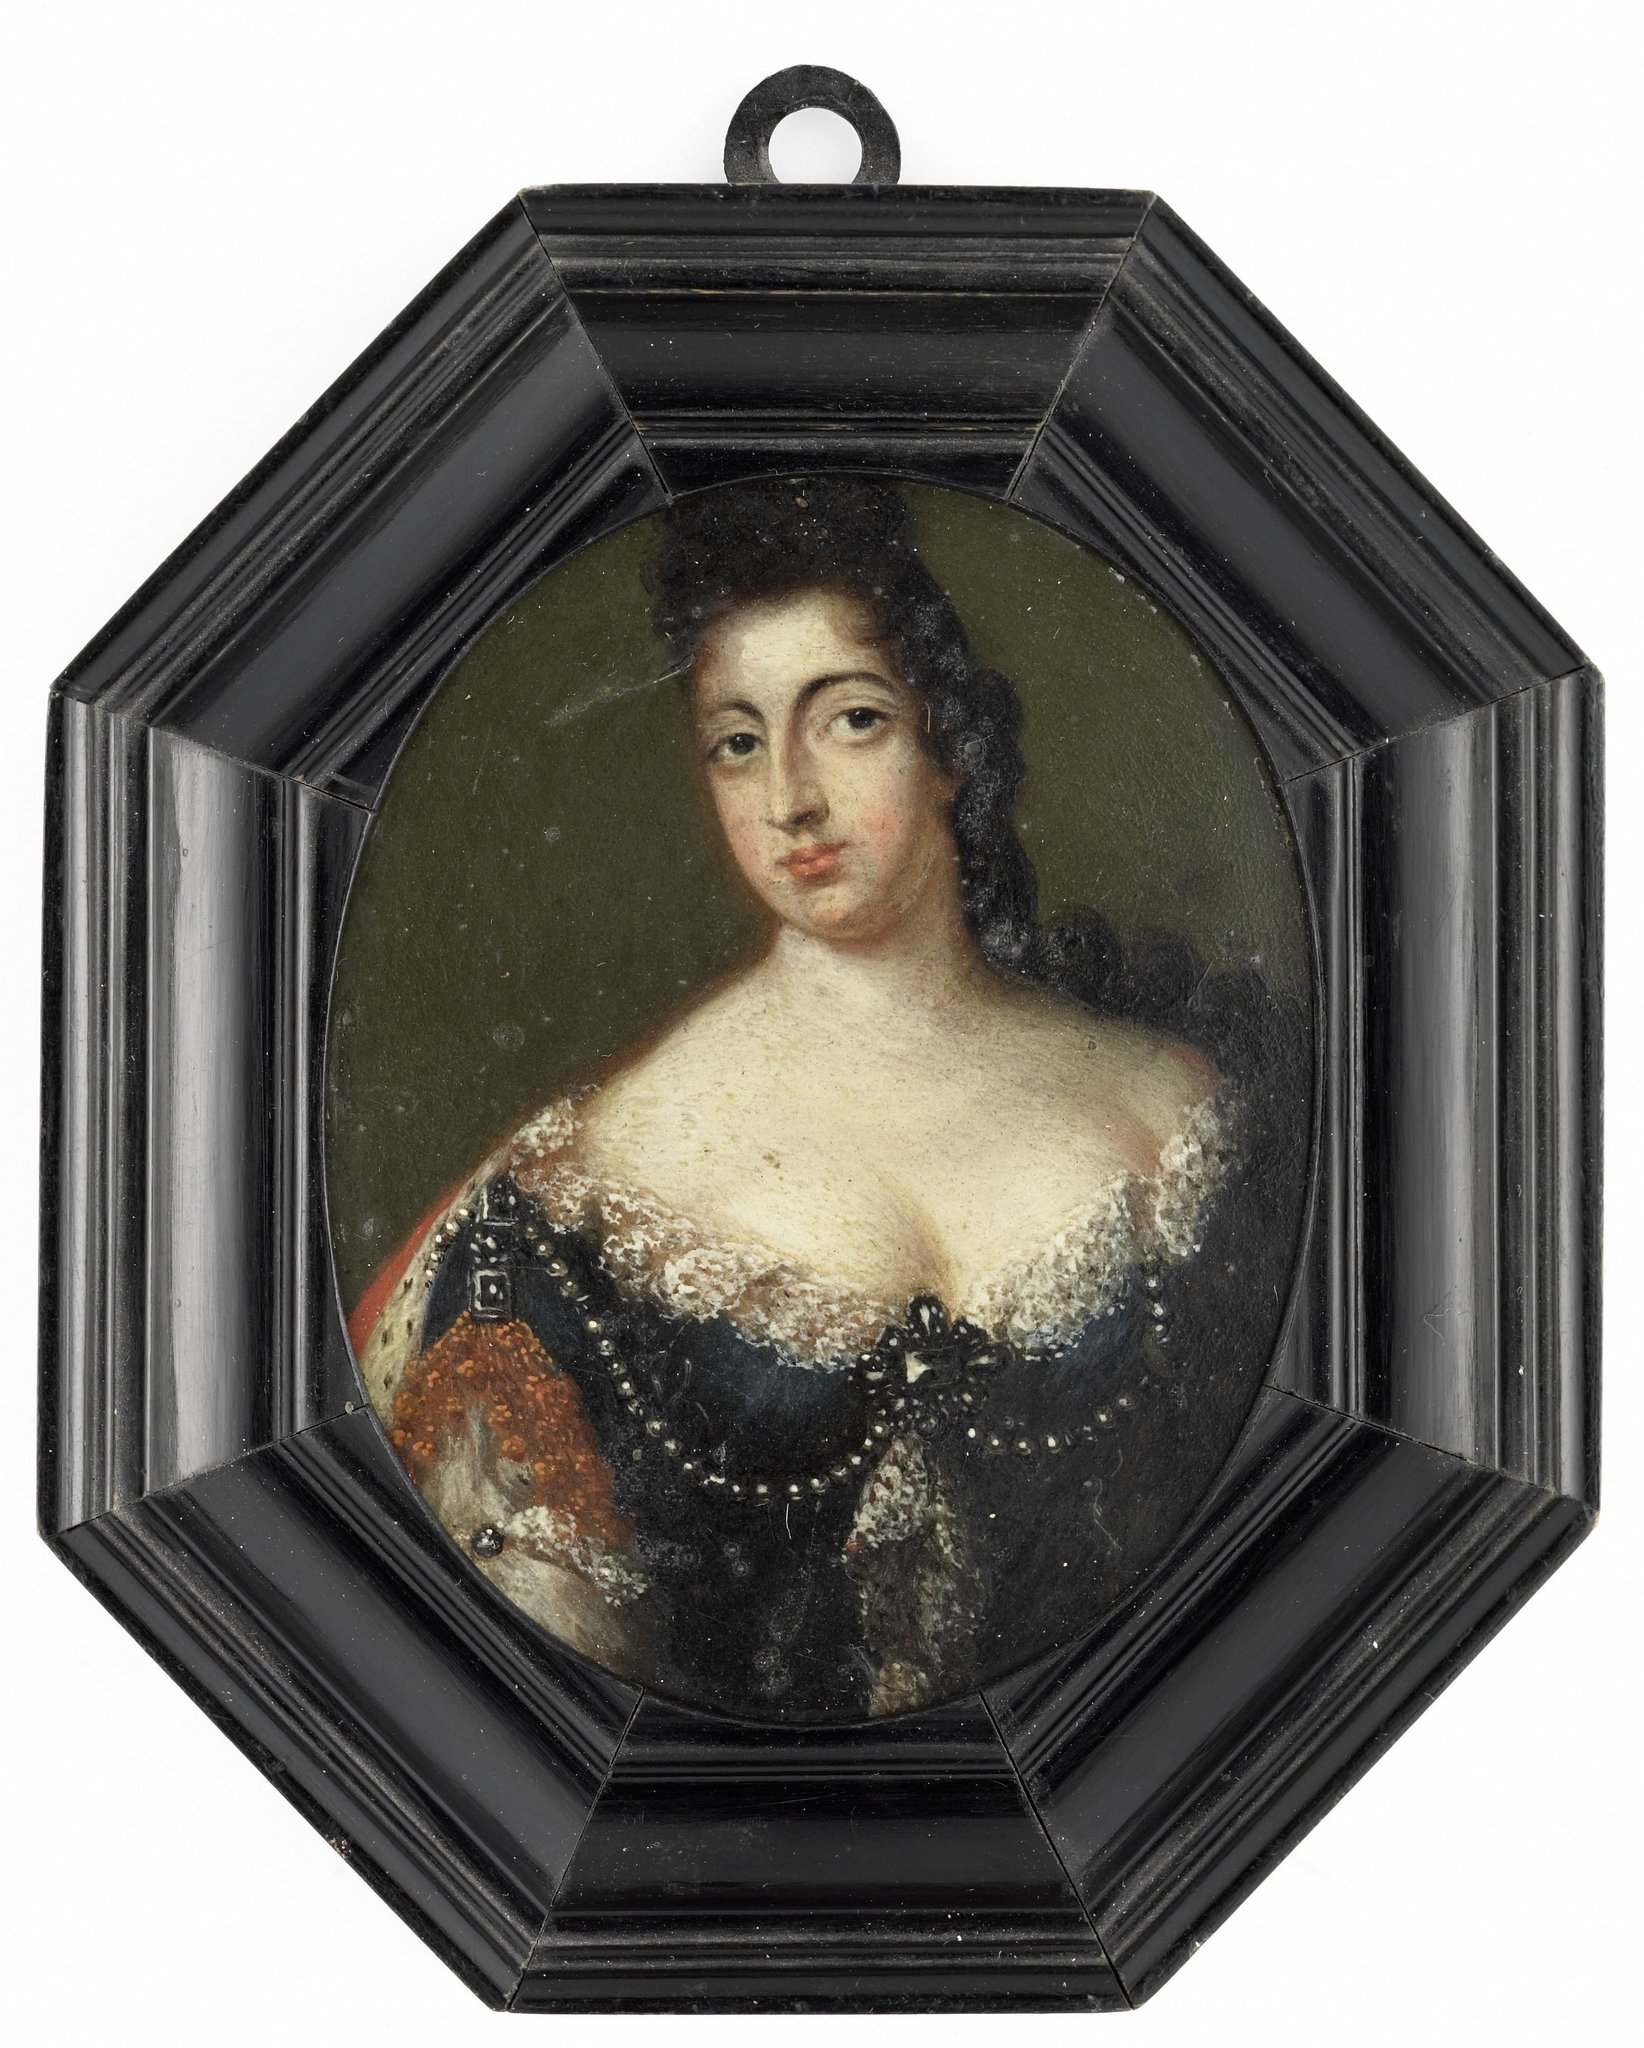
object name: painting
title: Portrait of Mary, Princess of Orange, Consort of William III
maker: Anonymous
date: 1695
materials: oil, tin, wood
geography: northern netherlands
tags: london, maria ii stuart (koningin van engeland, schotland en ierland)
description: Portretje van Maria Stuart (1662-95). Echtgenote van Willem III. Buste in ovaal, de blik naar boven gericht. Pendant van SK-A-4479.